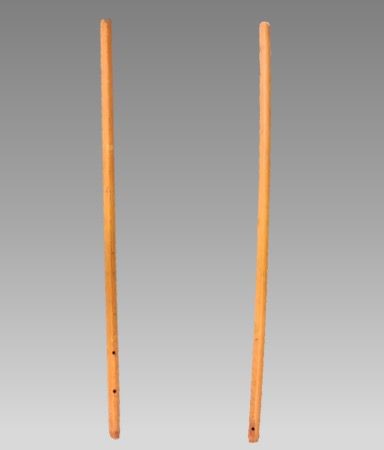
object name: gore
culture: melanesian, aoba island or vanuatuan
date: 1867-1900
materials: bamboo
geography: vanuatu